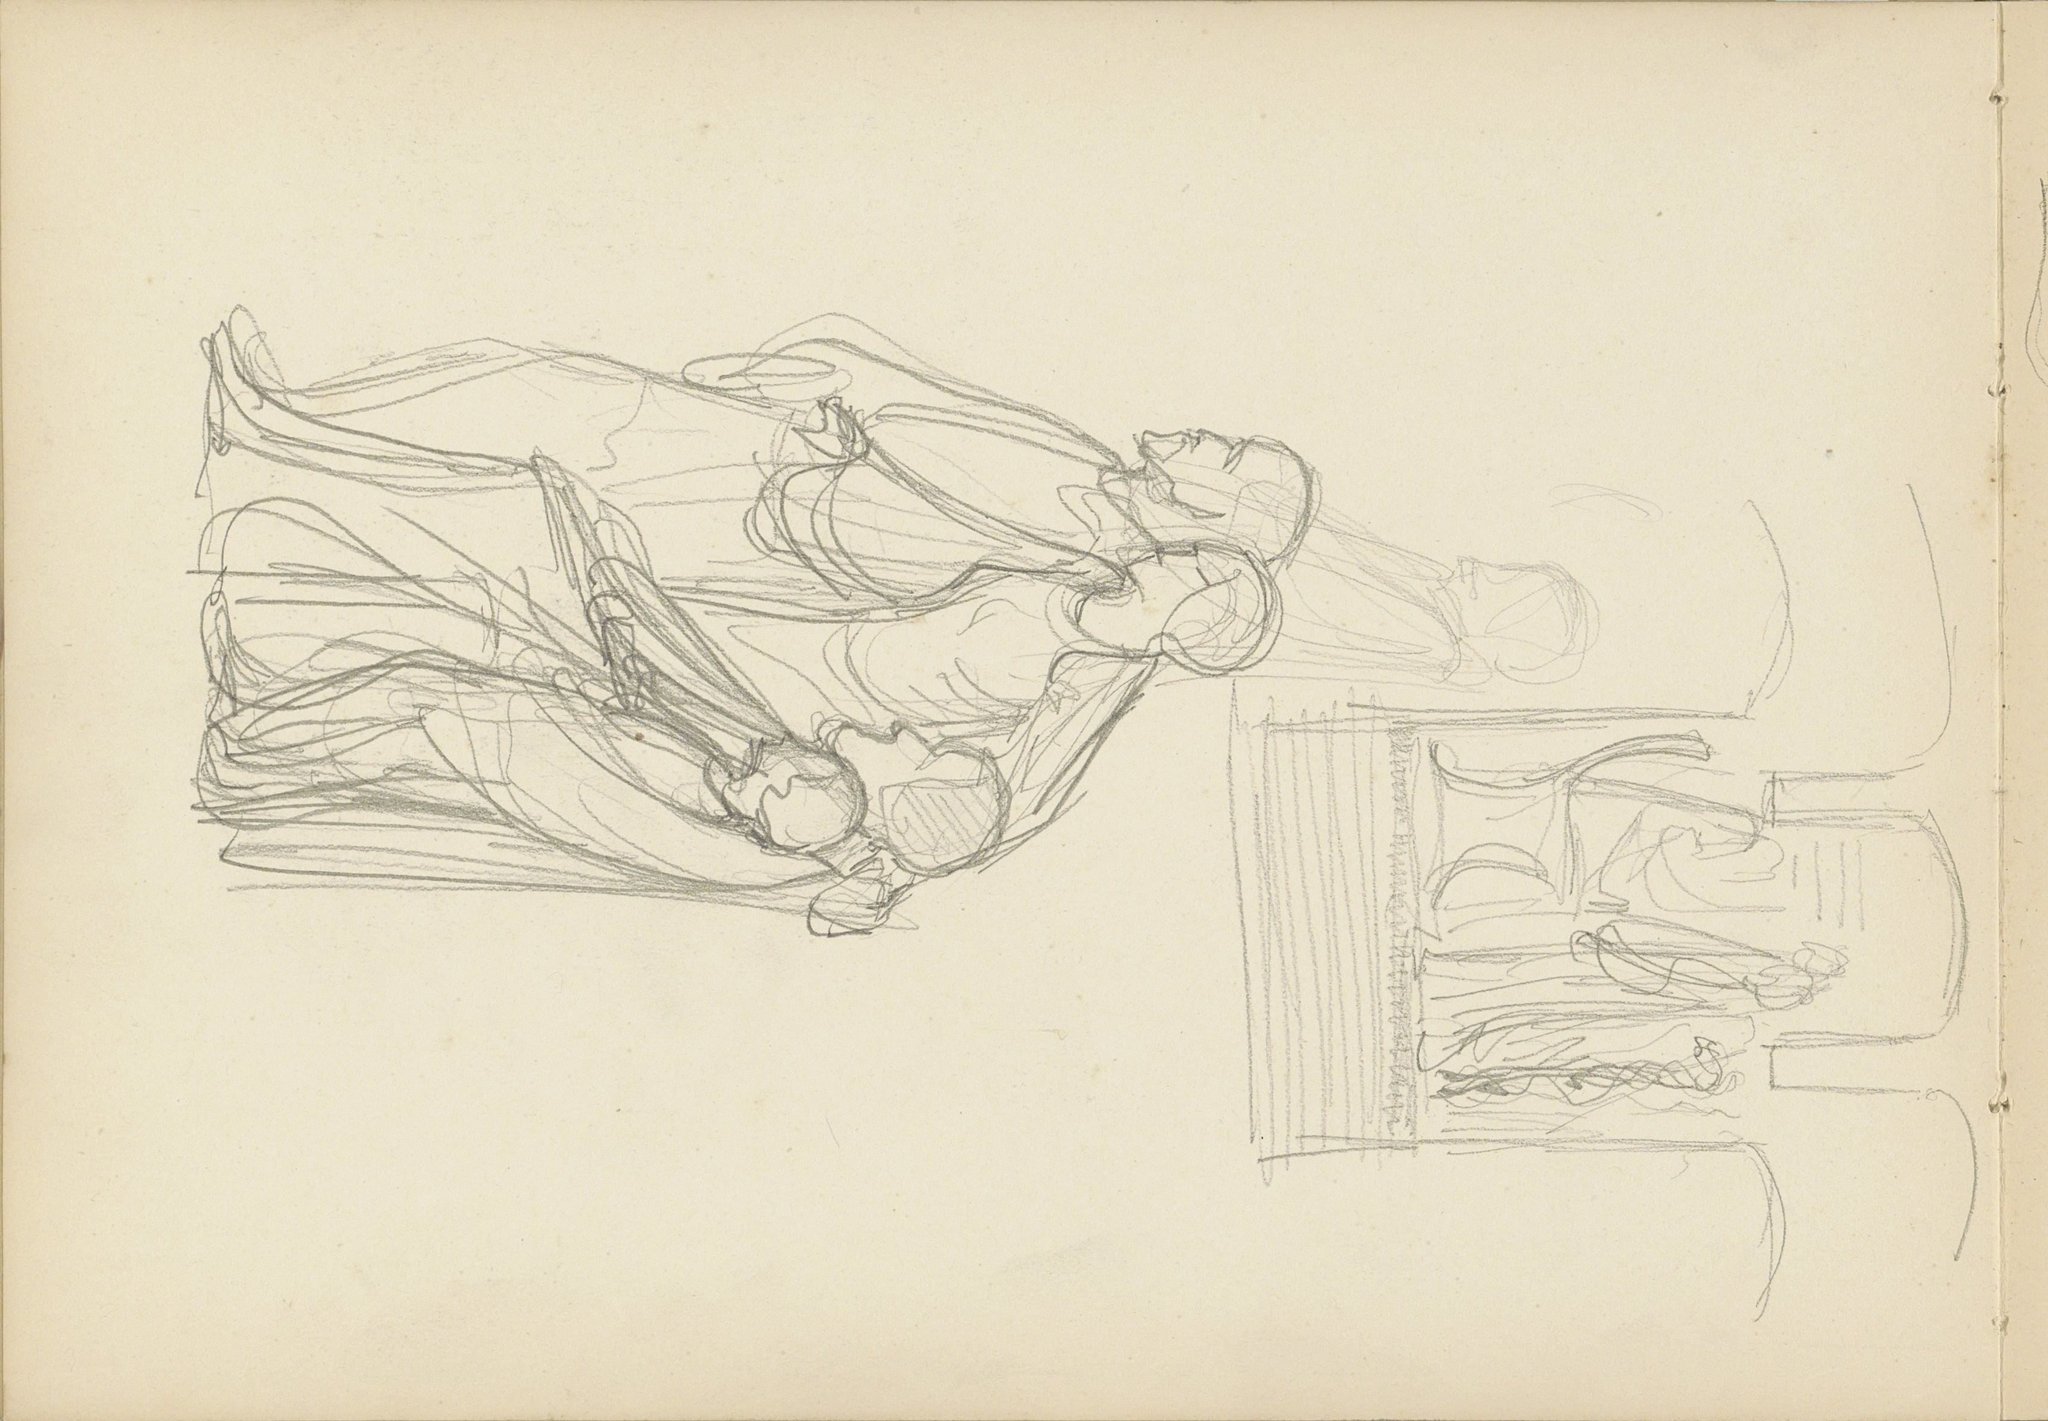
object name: sketchbook leaf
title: Familiegroep tegen een architecturale achtergrond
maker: antoon derkinderen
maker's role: draughtsman, painter, print maker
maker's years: 1859-1925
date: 1869-1925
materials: paper, pencil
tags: family group, especially parents with their child(ren), architecture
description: Blad 11 verso uit een schetsboek met 28 bladen.